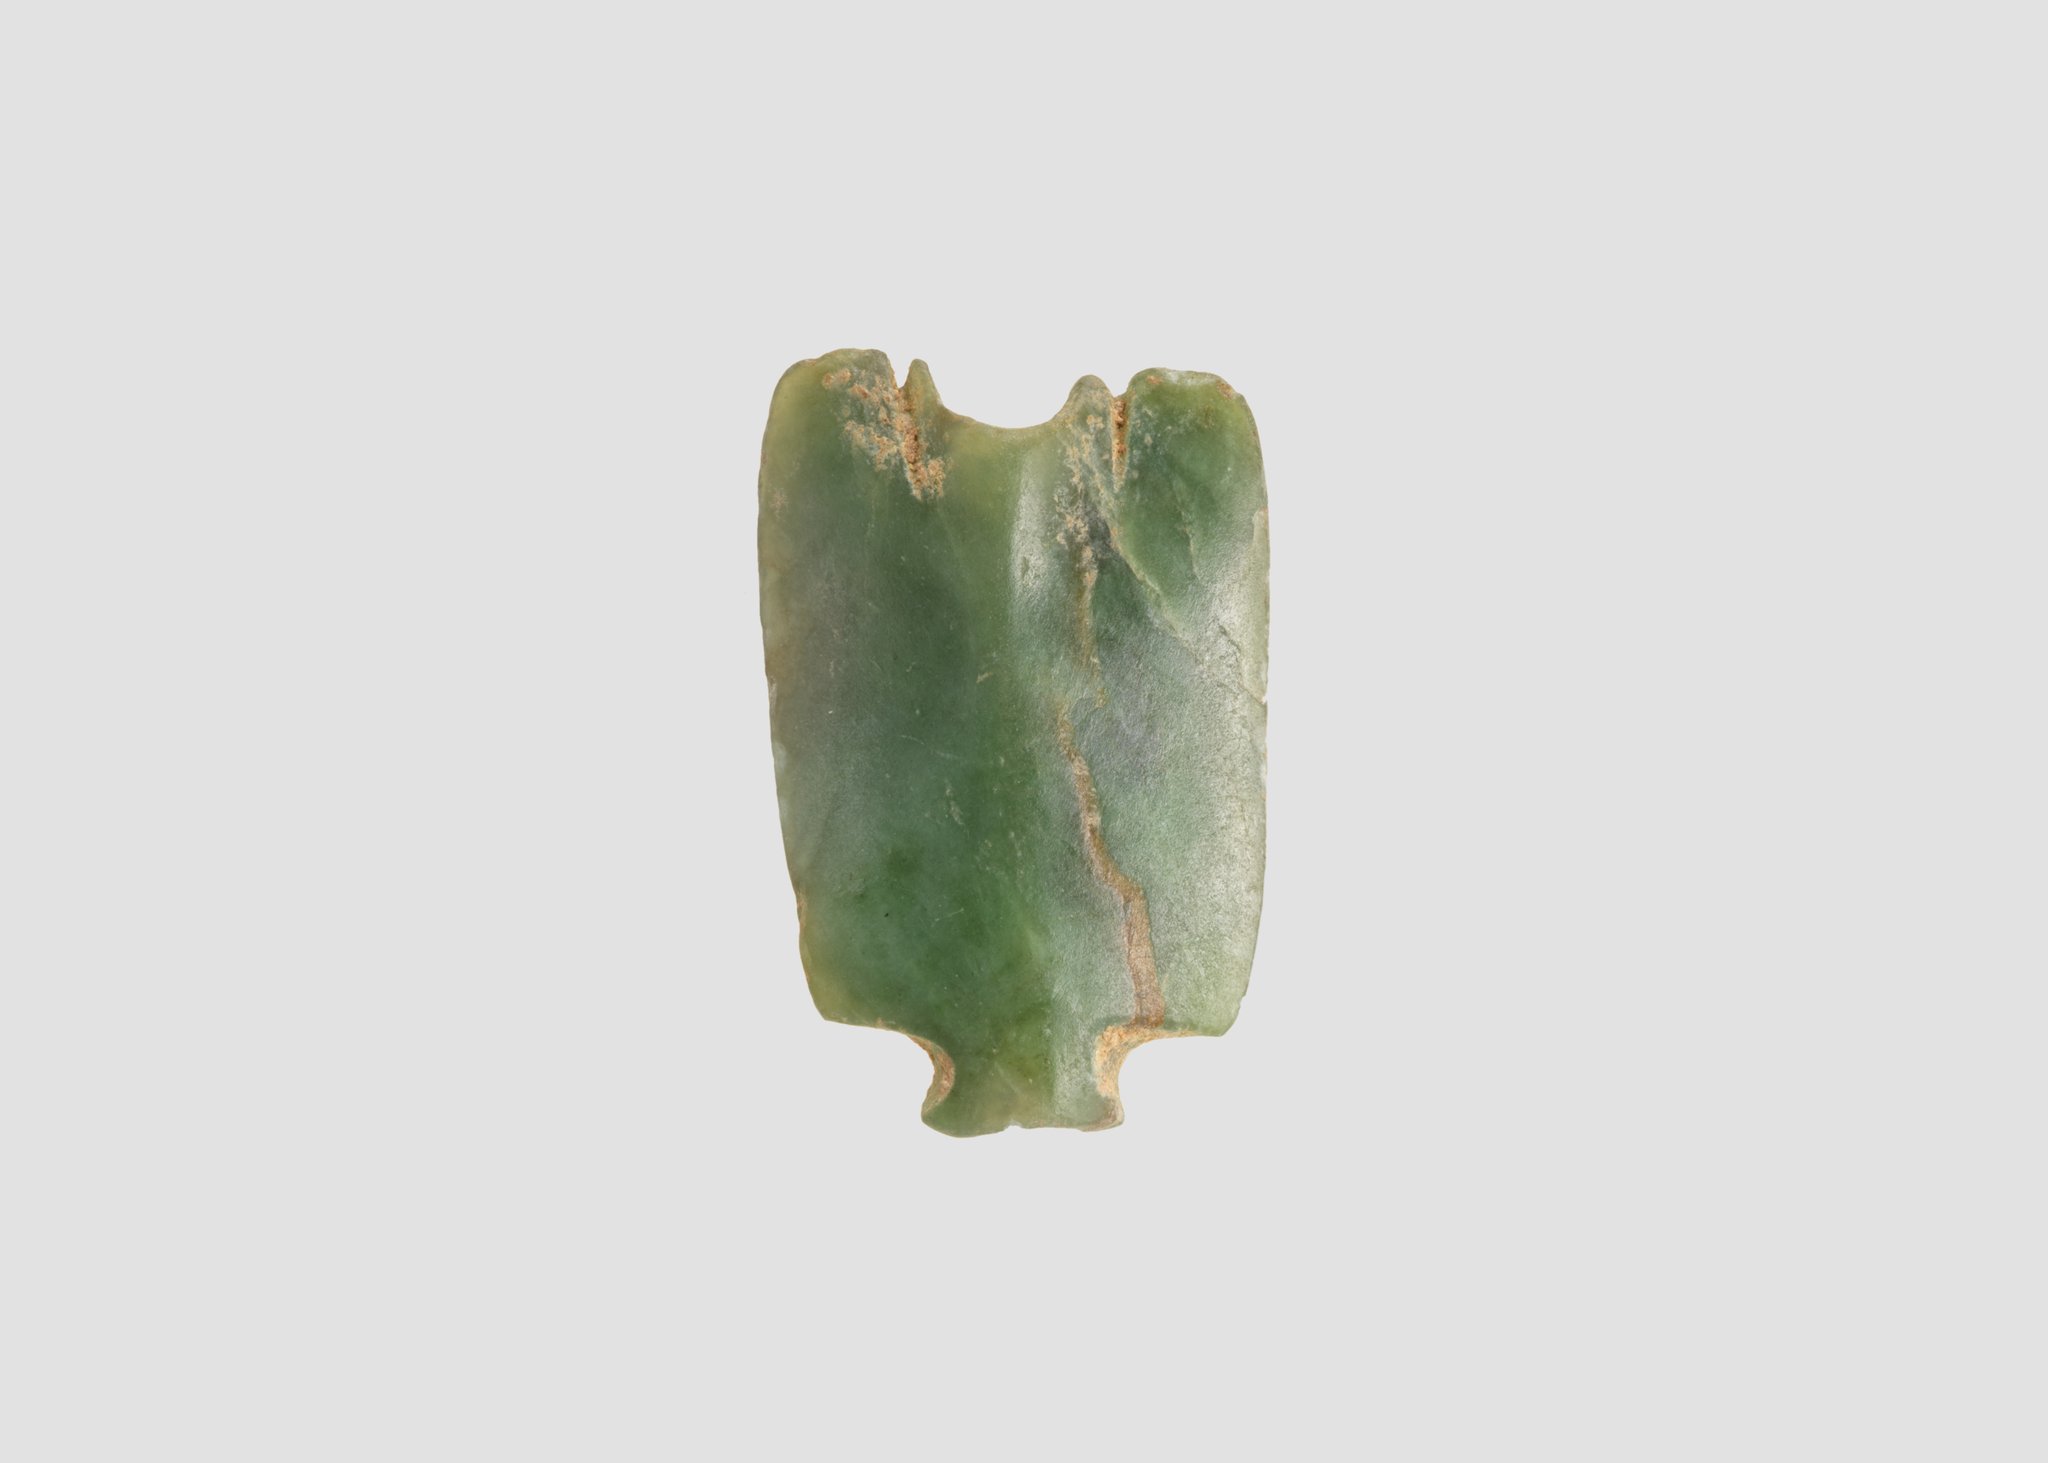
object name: bead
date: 7000-5001 BCE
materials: jade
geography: syria